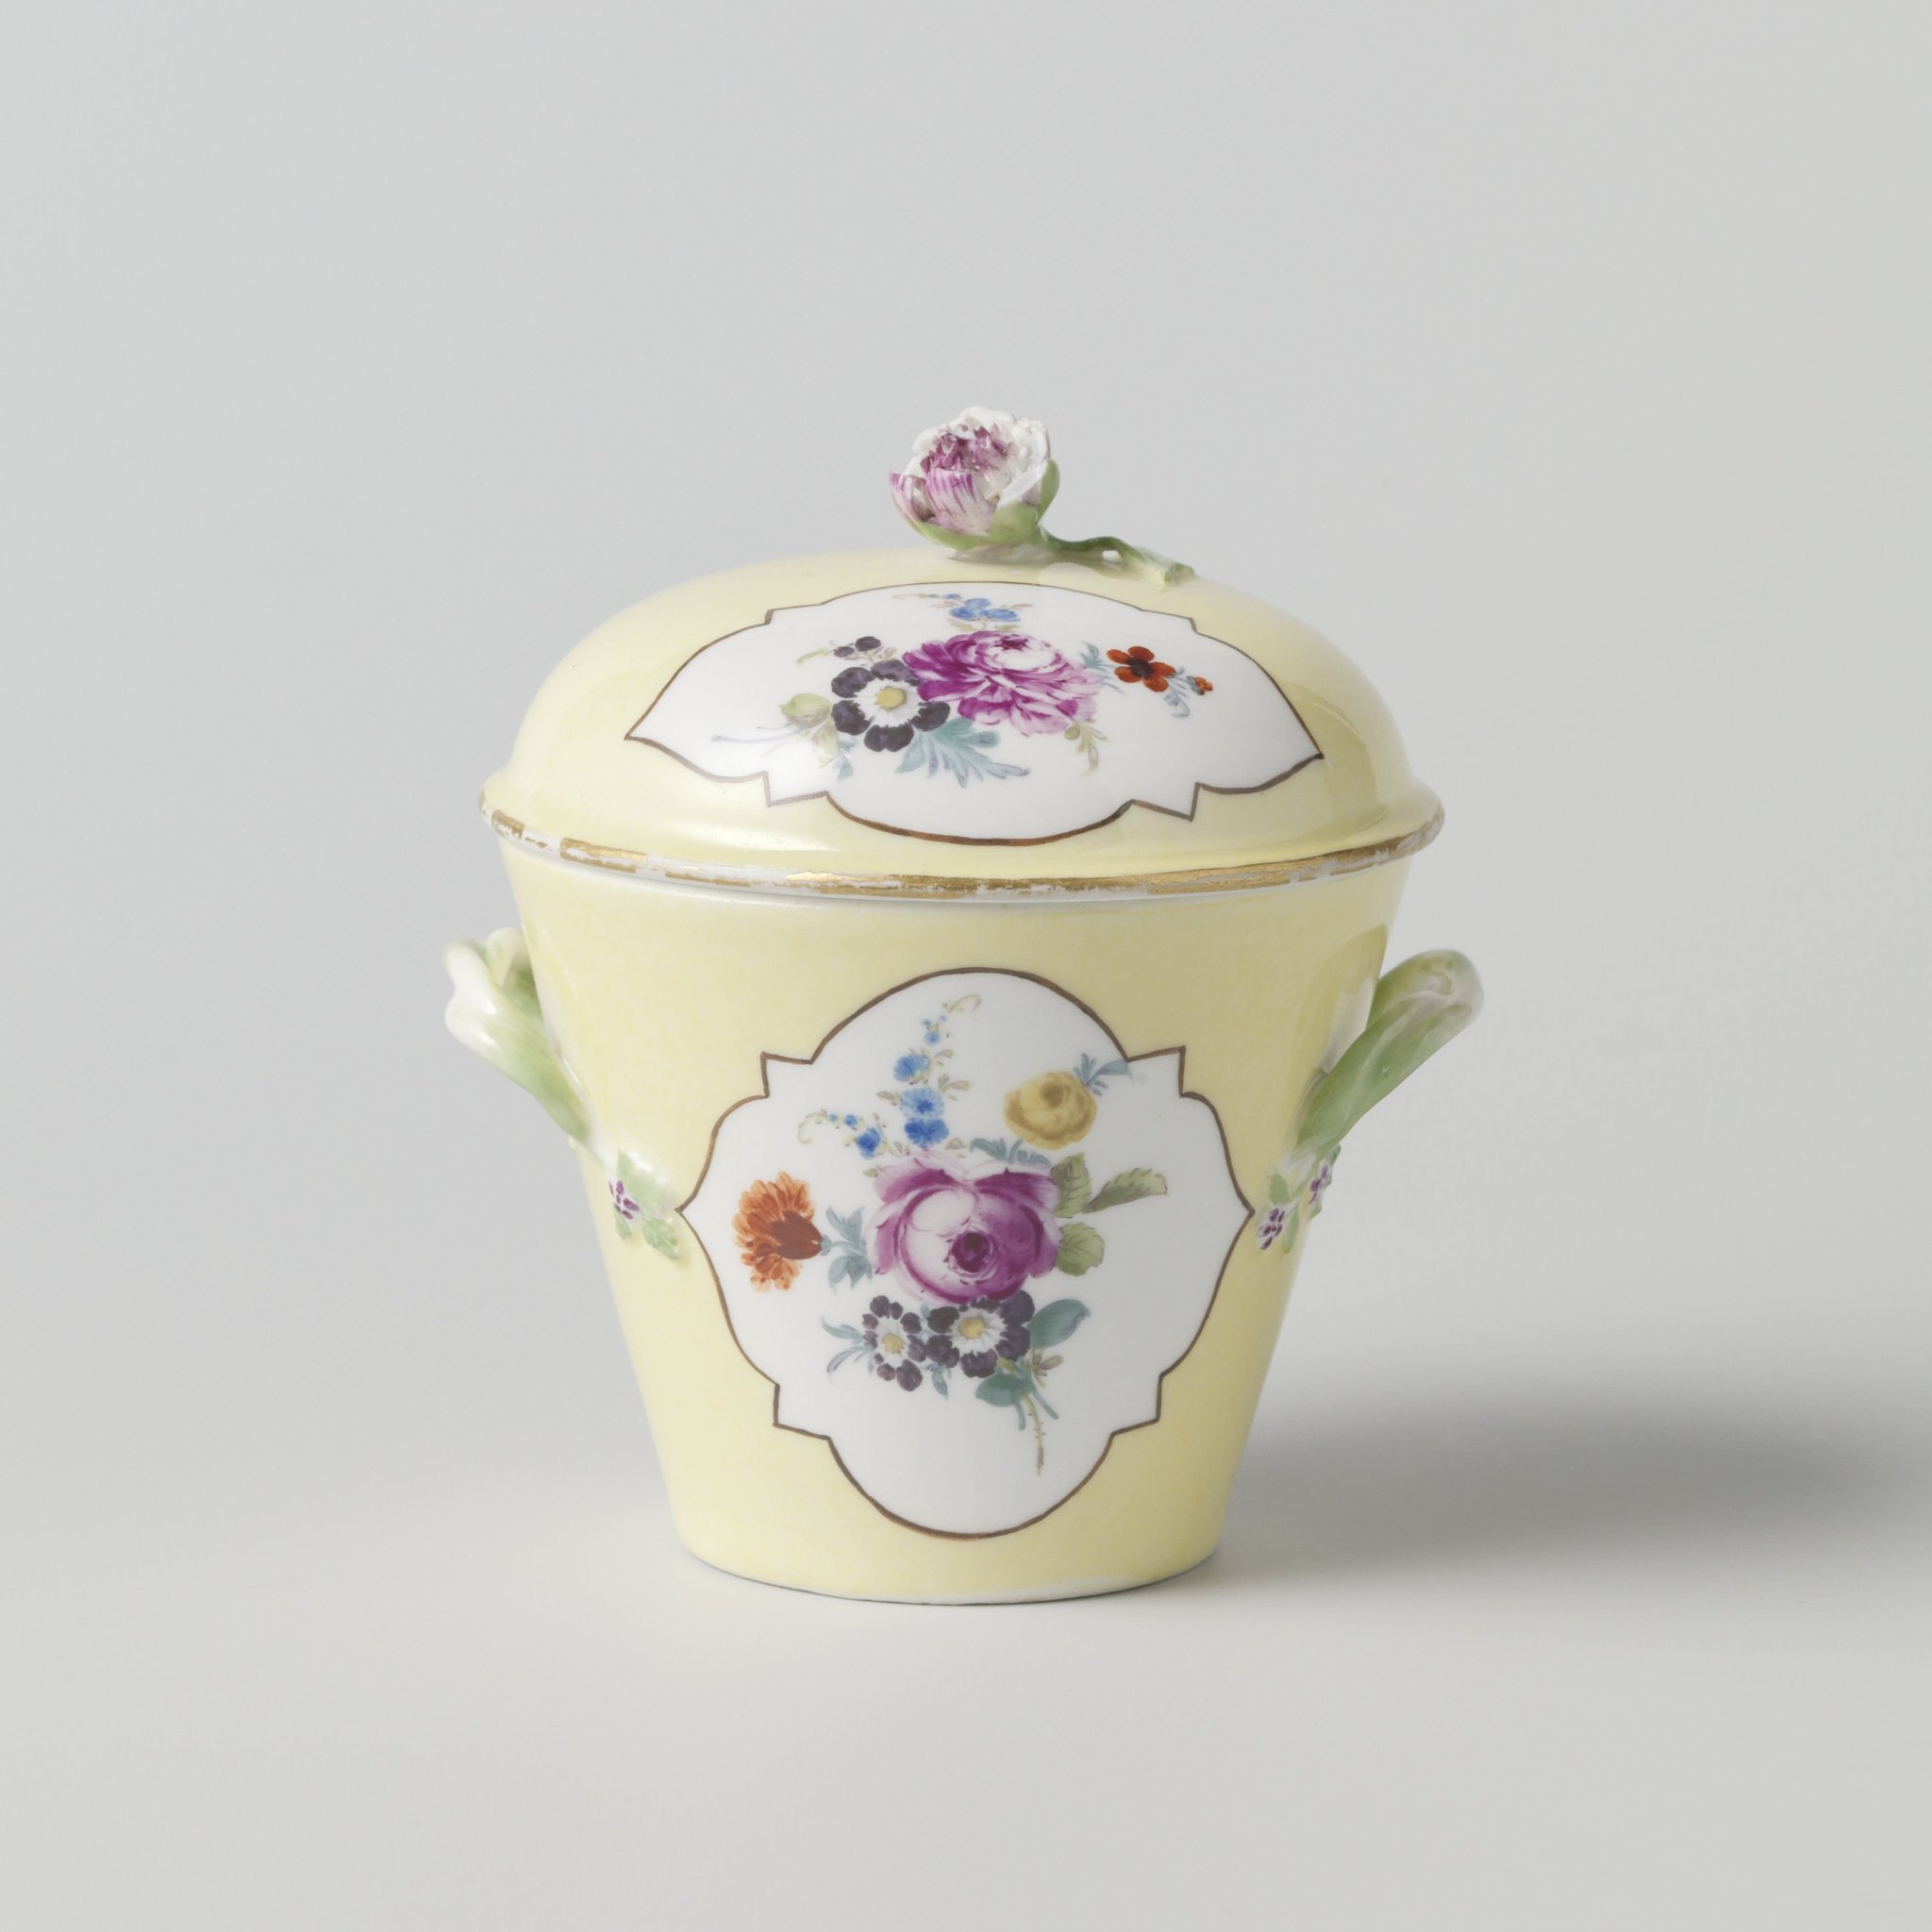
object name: sugar box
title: Suikerpot, veelkleurig beschilderd met Deutsche Blumen in uitgespaarde vierpassen in een gele fond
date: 1765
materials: porcelain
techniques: painted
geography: meissen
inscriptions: mold mark: ‘32’, mark, factory mark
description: Bekervormige suikerpot van beschilderd porselein. De pot is bedekt met een gele fond met uitgespaarde vierpassen waarin Deutsche Blumen. De pot heeft twee oren in de vorm van gedraaide bloemtakken. De suikerpot is gemerkt.